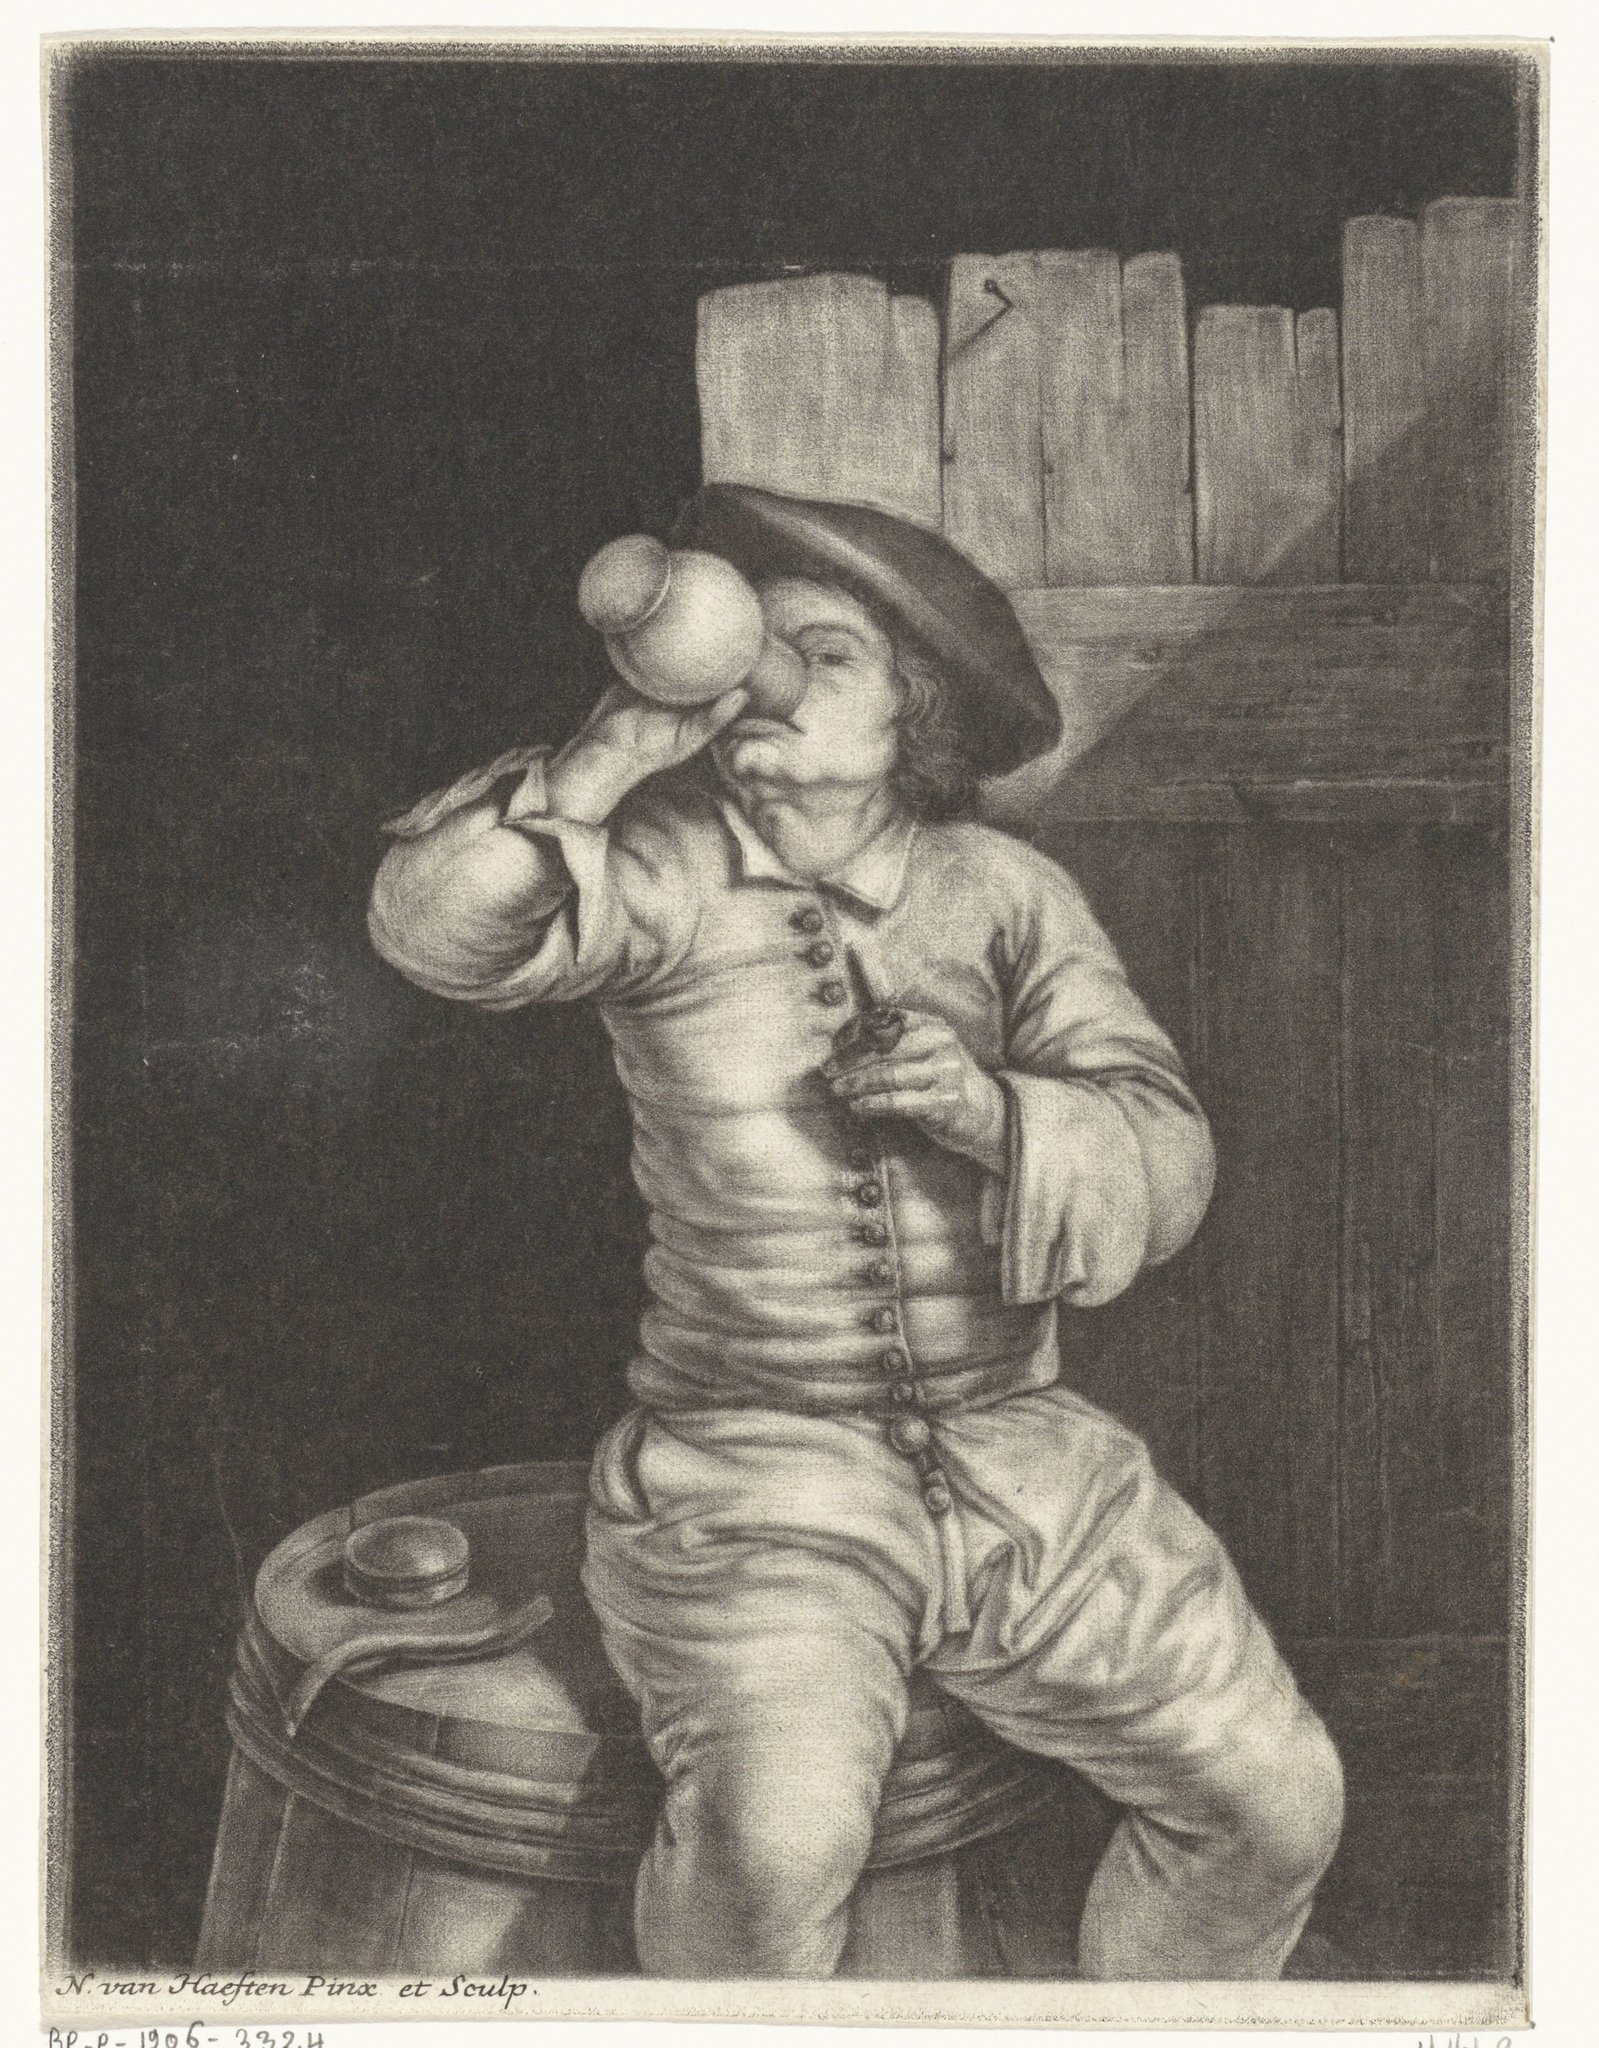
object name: print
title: Drinkende man op een ton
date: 1673-1715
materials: paper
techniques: engraving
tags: pipe ~ tobacco, jar, jug (used as drinking-vessel)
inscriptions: collector's mark: Lugt 2228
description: Een man met een pijp in de hand zit op een vat en drinkt uit een kan.